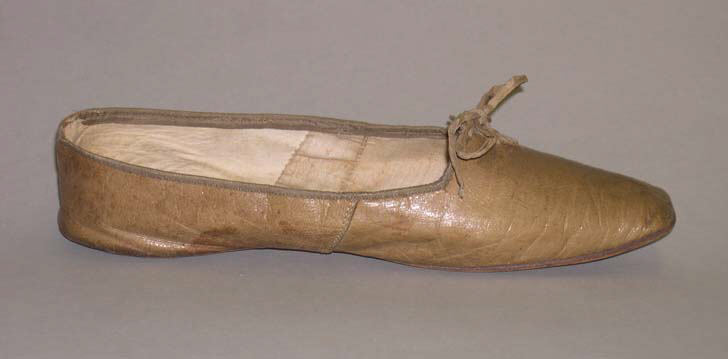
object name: slipper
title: Slippers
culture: american or european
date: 1830-1839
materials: leather